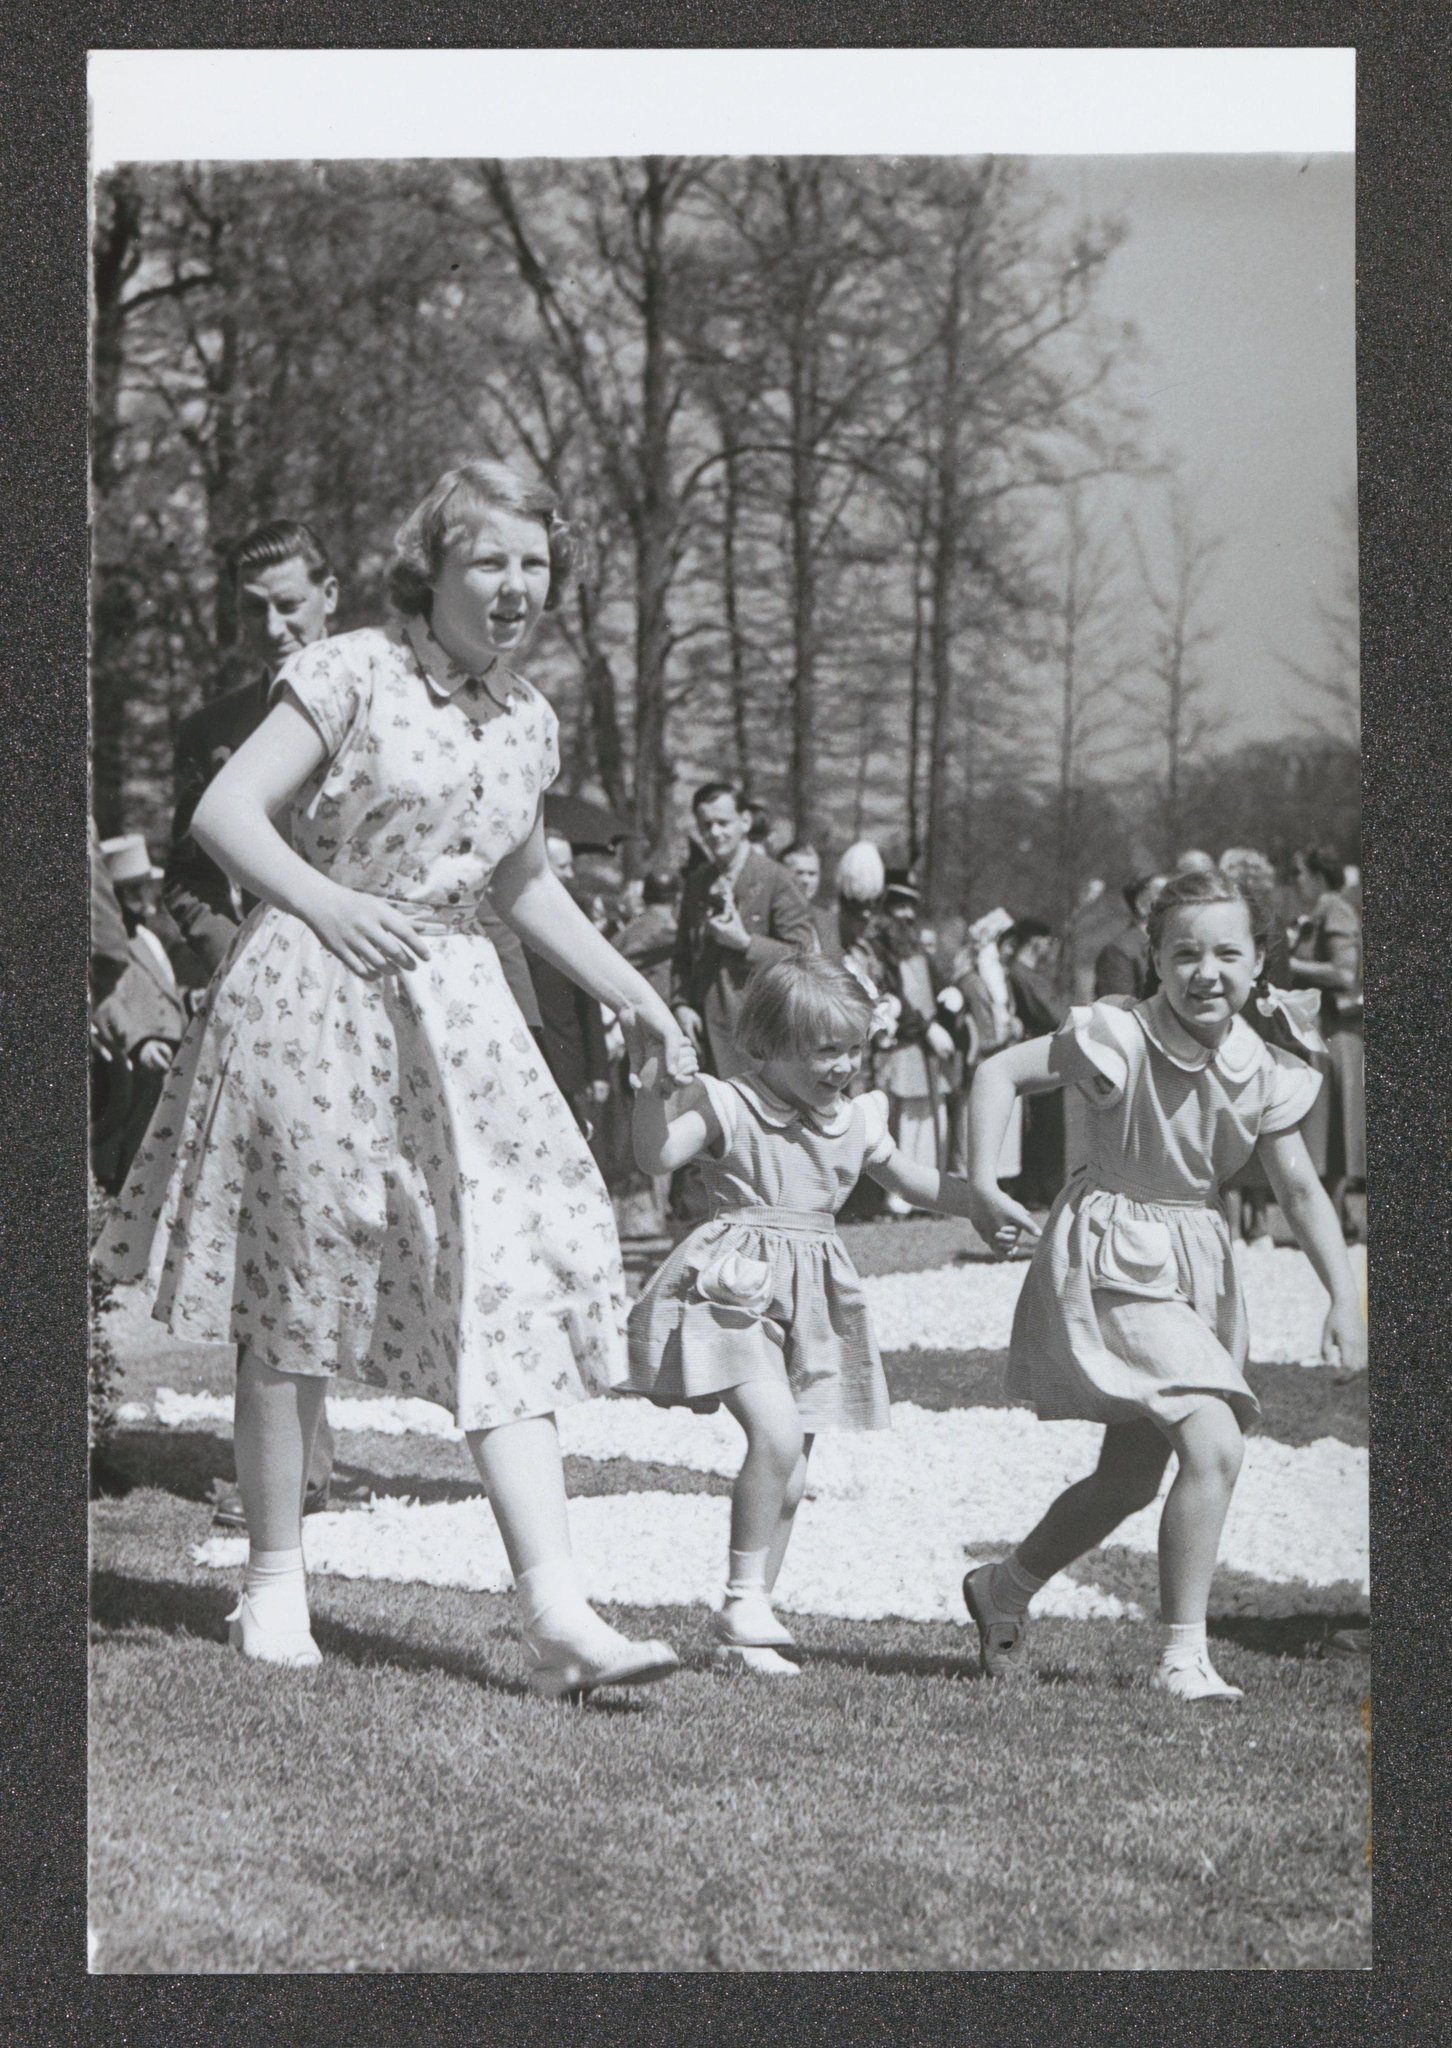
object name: photograph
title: Prinses Beatrix, Marijke en Margriet tijdens het bloemendéfilé voor paleis Soestdijk op de verjaardag van hun moeder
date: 1952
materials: paper, photographic support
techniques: gelatin silver print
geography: netherlands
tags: the hague, beatrix (koningin der nederlanden)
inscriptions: annotation: ‘Saturdasy 31st,1959,H.R.H.Crown Princess / Beatrix celebrates Her 21st birthday and thus / attains Her majority. // Picture from the files: H.R.H.Pr.Beatrix / during flowerfefile on April 30th,1952, at / the Palace Soestdijk. / f.l.t.r:the Princesses Beatrix,Marijke and / Margriet. / PHOTO-ANEFO 28-1-1959’